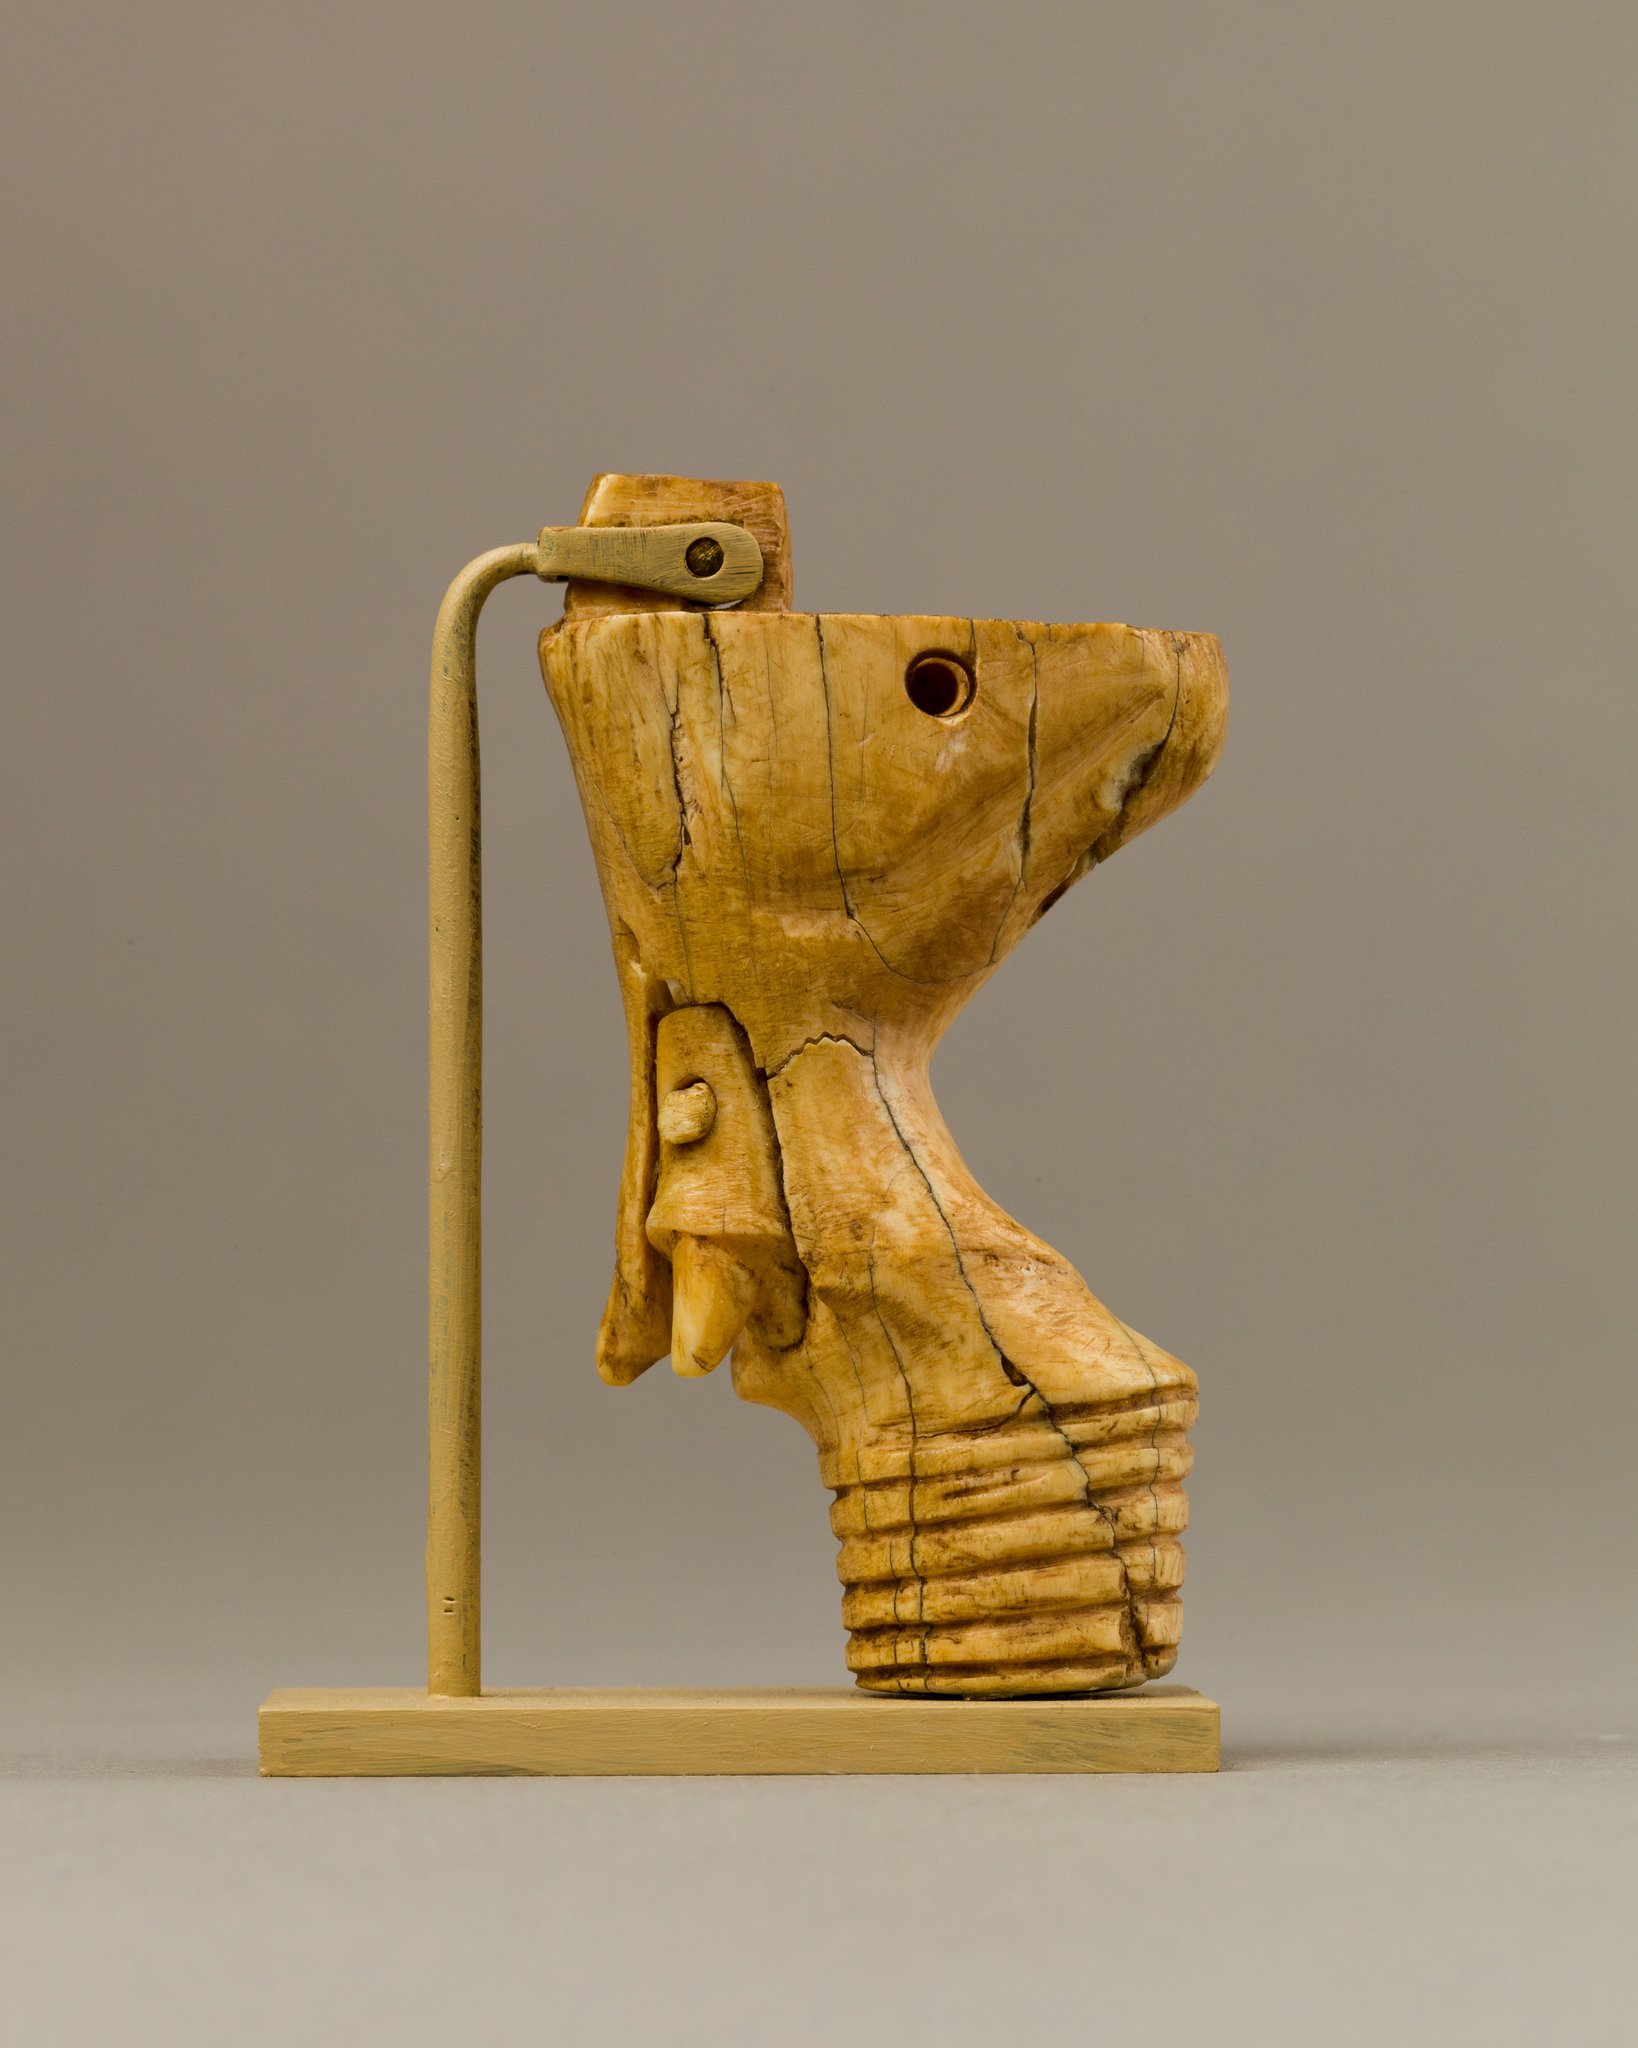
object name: furniture leg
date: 3100-2900 BCE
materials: ivory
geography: egypt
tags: furniture